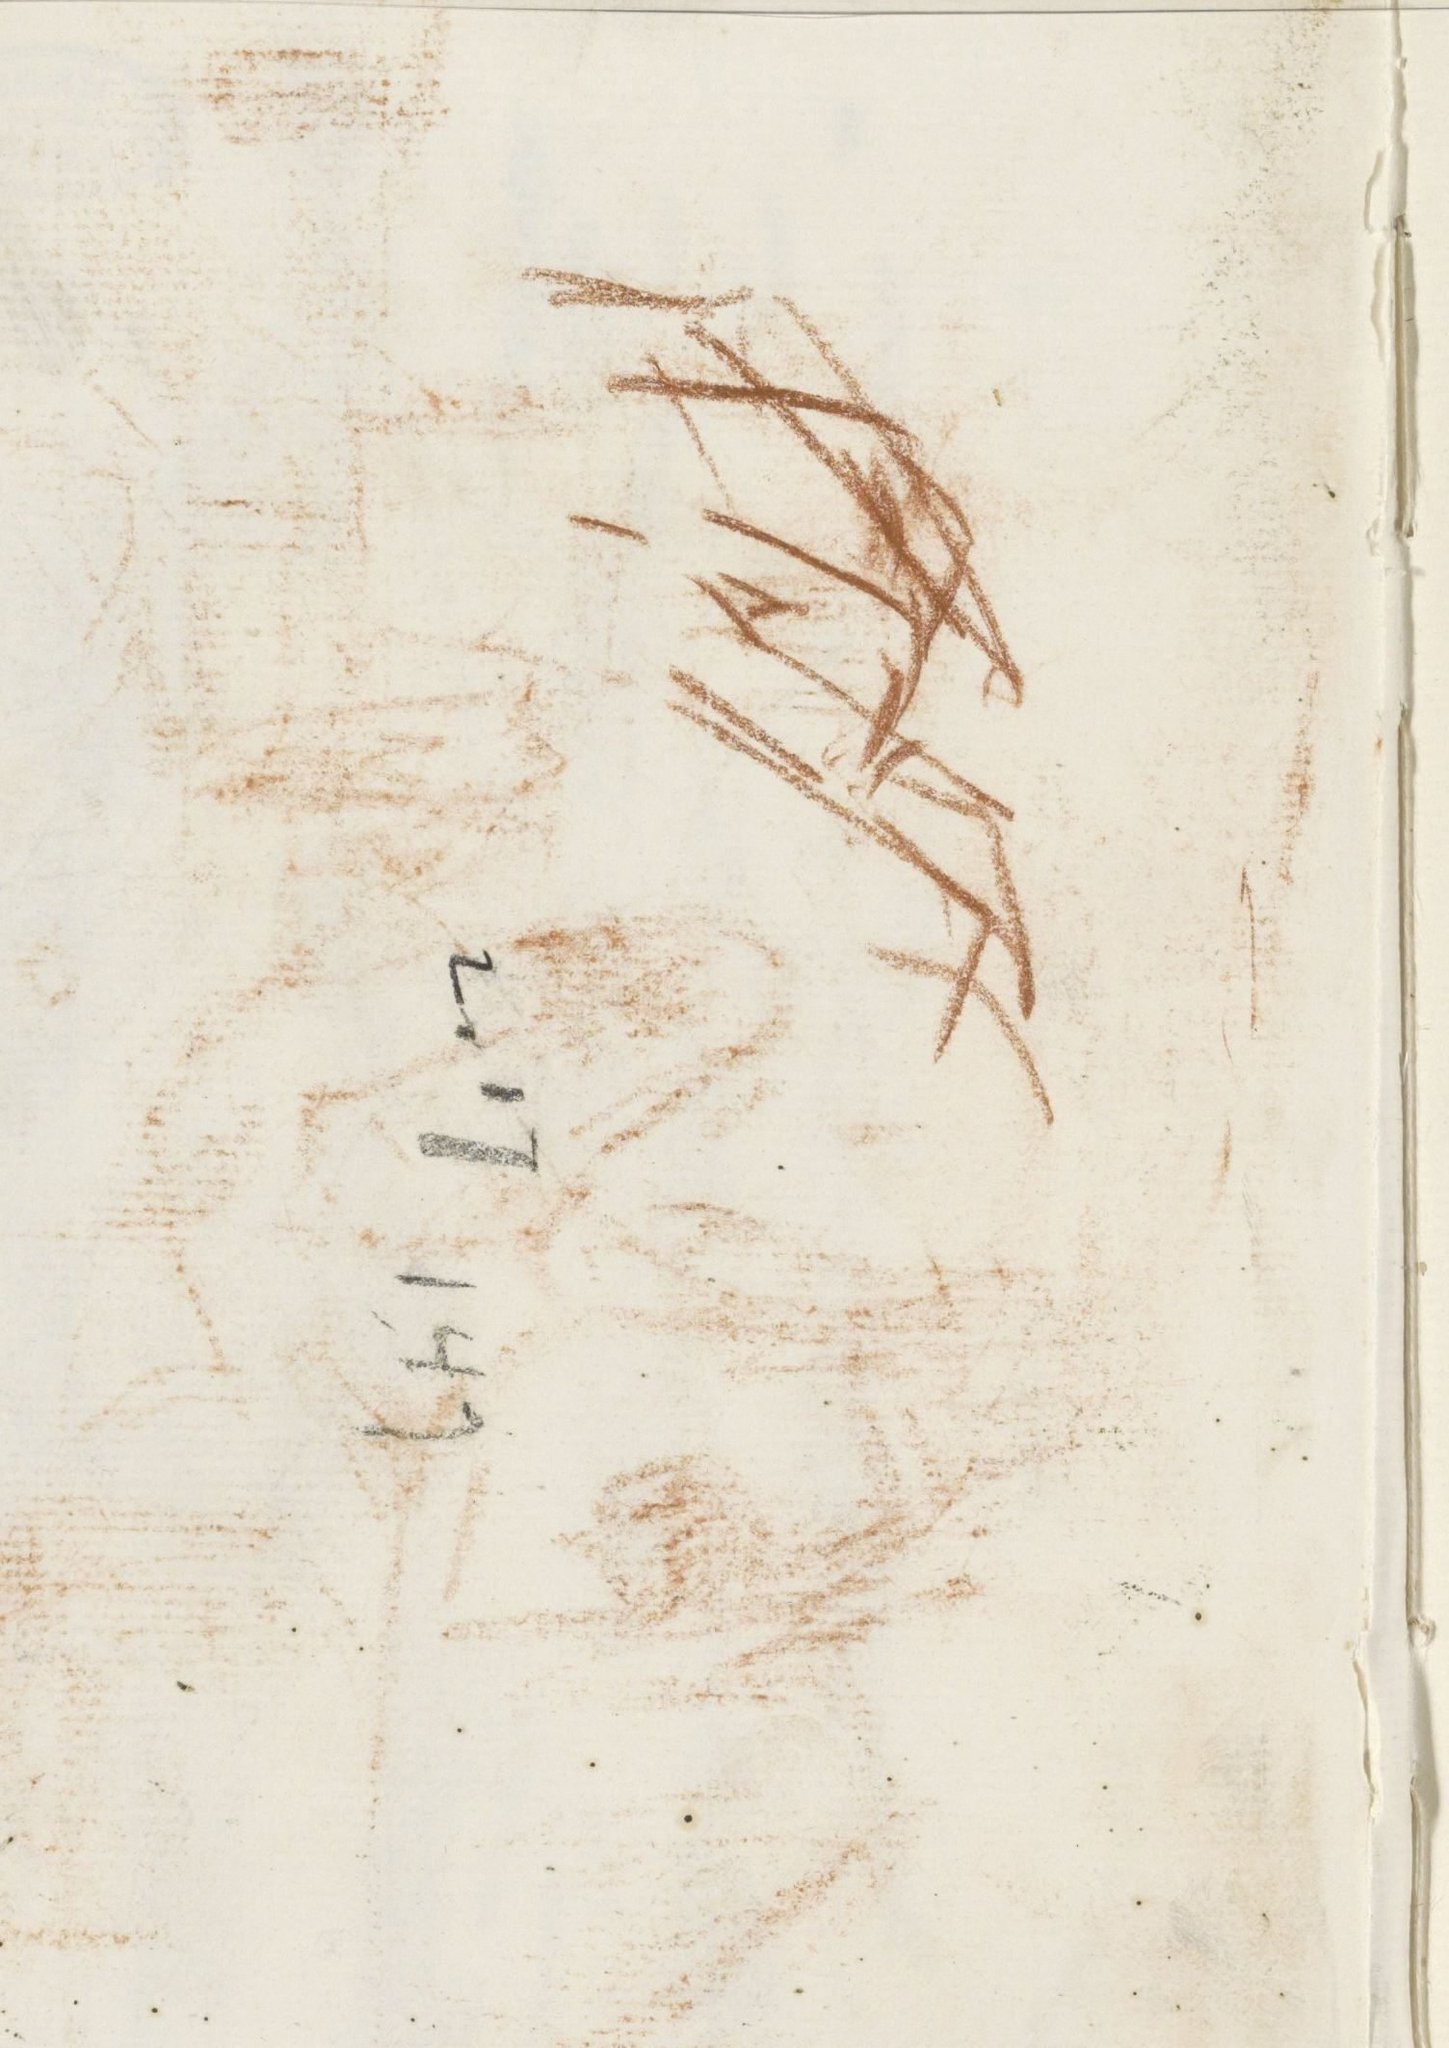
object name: sketchbook leaf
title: Studie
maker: george hendrik breitner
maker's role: draughtsman, painter, print maker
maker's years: 1857-1923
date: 1888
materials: chalk, paper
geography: amsterdam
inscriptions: annotation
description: Pagina 9 uit een schetsboek met 6 bladen.